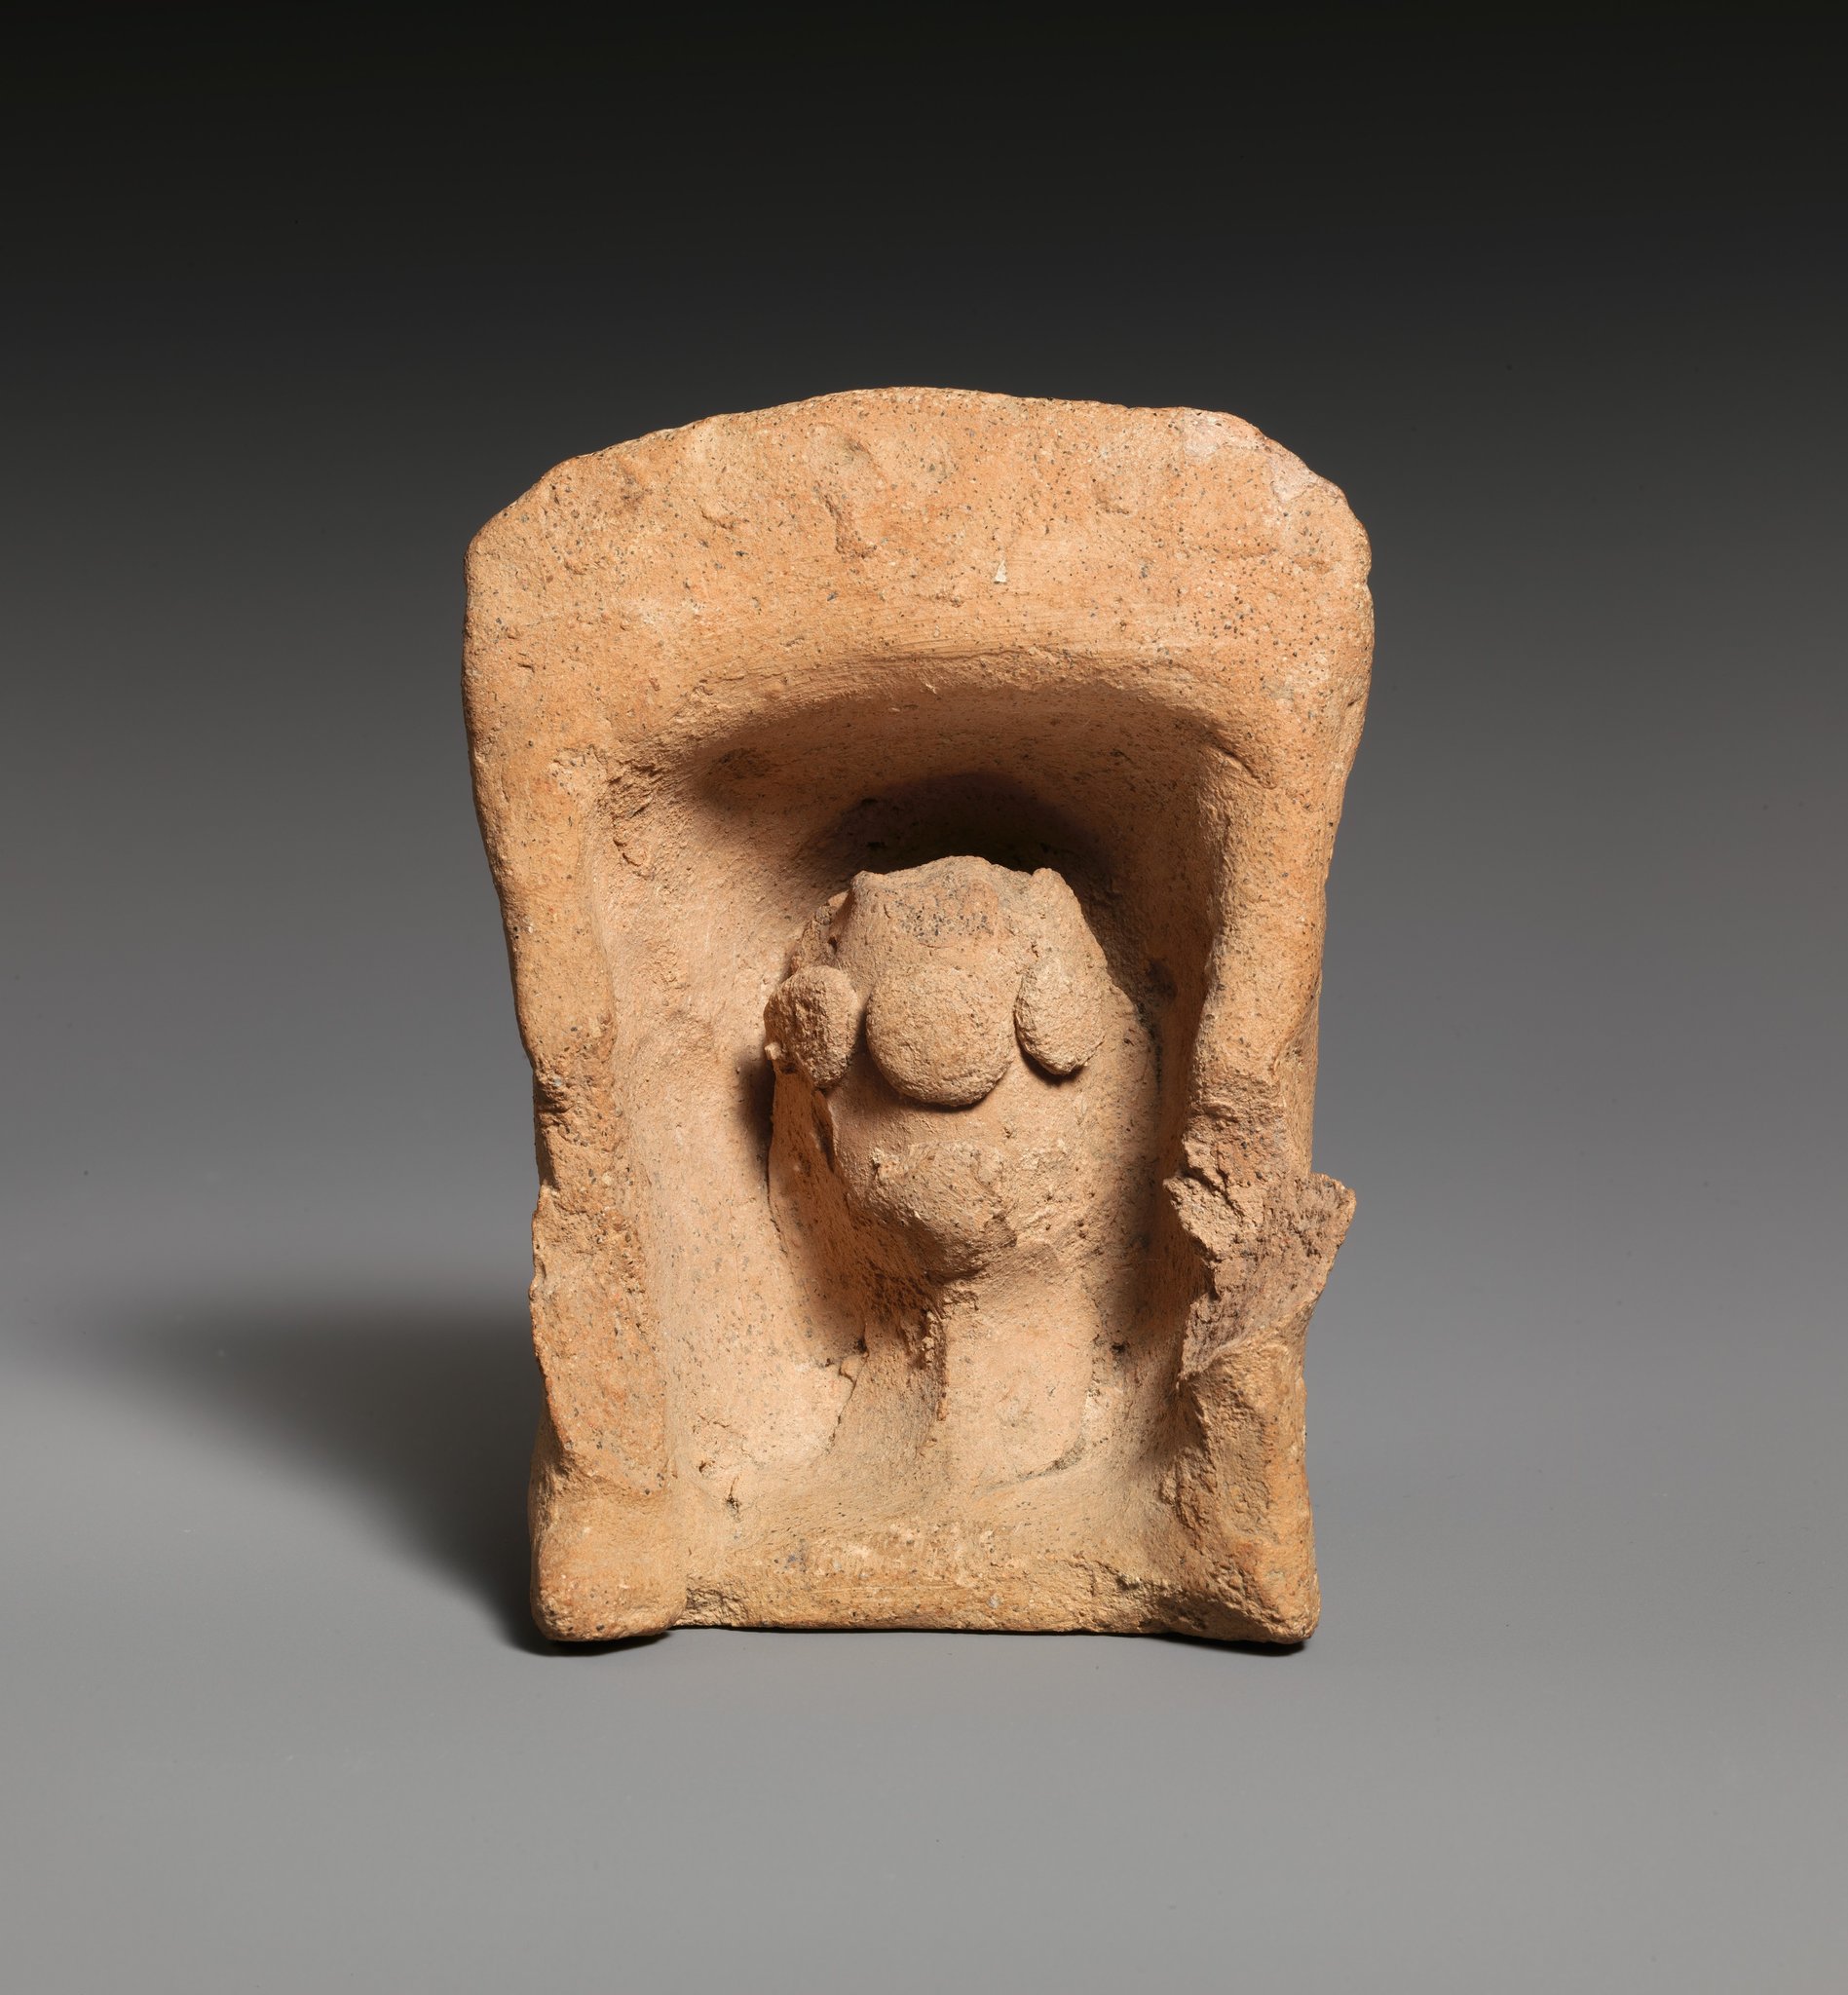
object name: altar shrine with divinity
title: Terracotta model of a shrine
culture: cypriot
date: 600-480 BCE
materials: terracotta